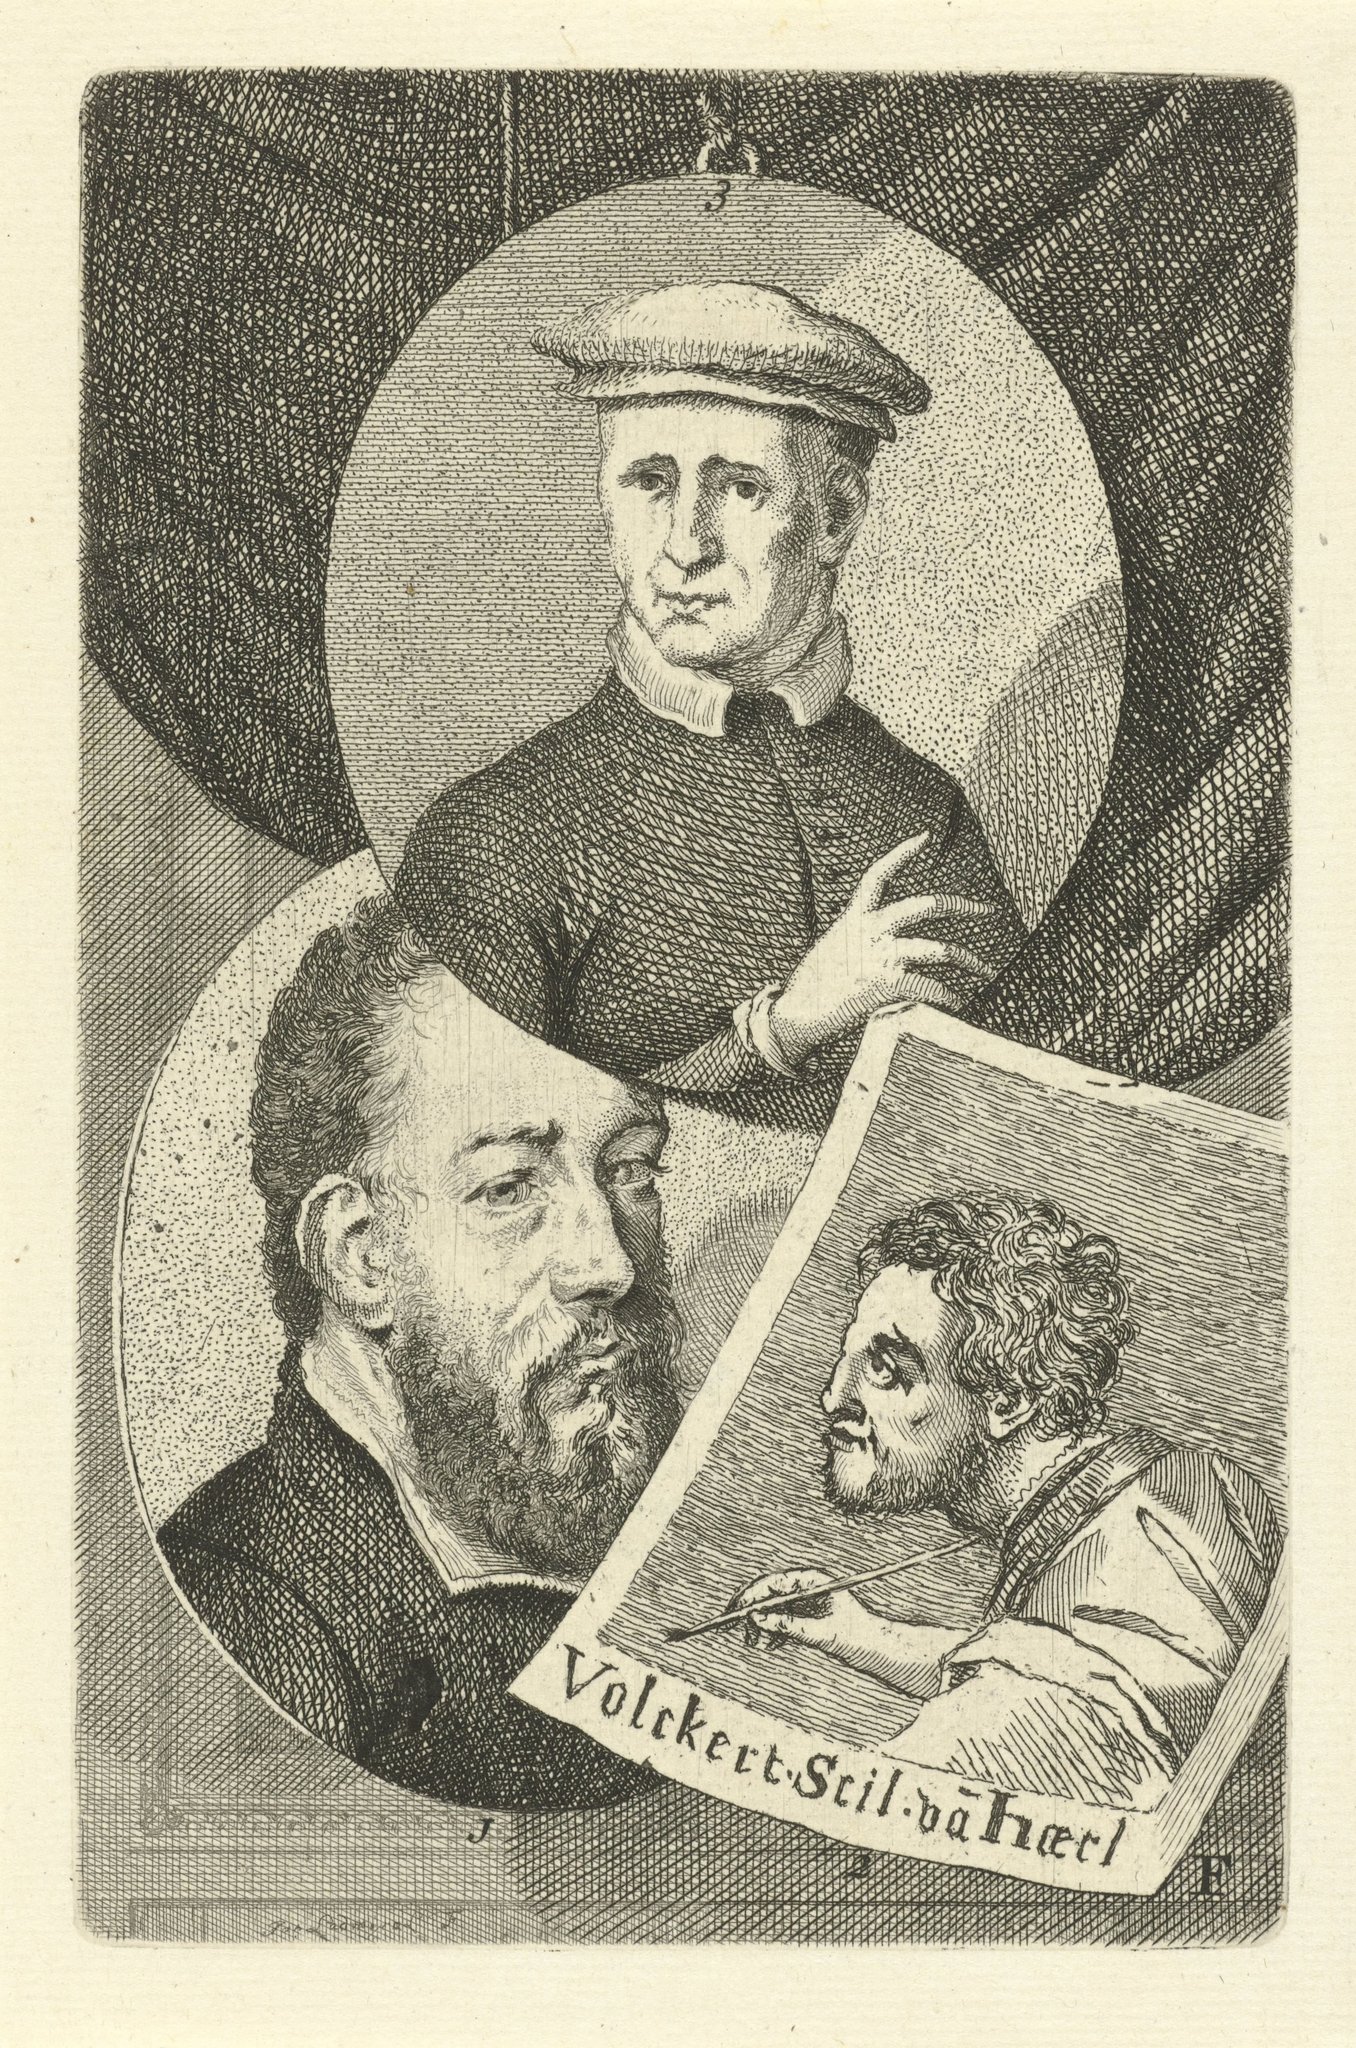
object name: book illustration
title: Portretten van Lambertus Suavius, Volckert Claesz. en Dirck Jacobsz.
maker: jan l admiral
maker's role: draughtsman, print maker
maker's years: 1699-1773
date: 1764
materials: paper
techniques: etching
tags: liège, print maker, lambertus suavius, painter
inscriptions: collector's mark: Lugt 2228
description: Prent opgenomen in: Mander, Karel van; Jongh, Jacobus de (vert.). Het leven der doorluchtige Nederlandsche en eenige Hoogduitsche schilders. Amsterdam: Steven van Esveldt, 1764.